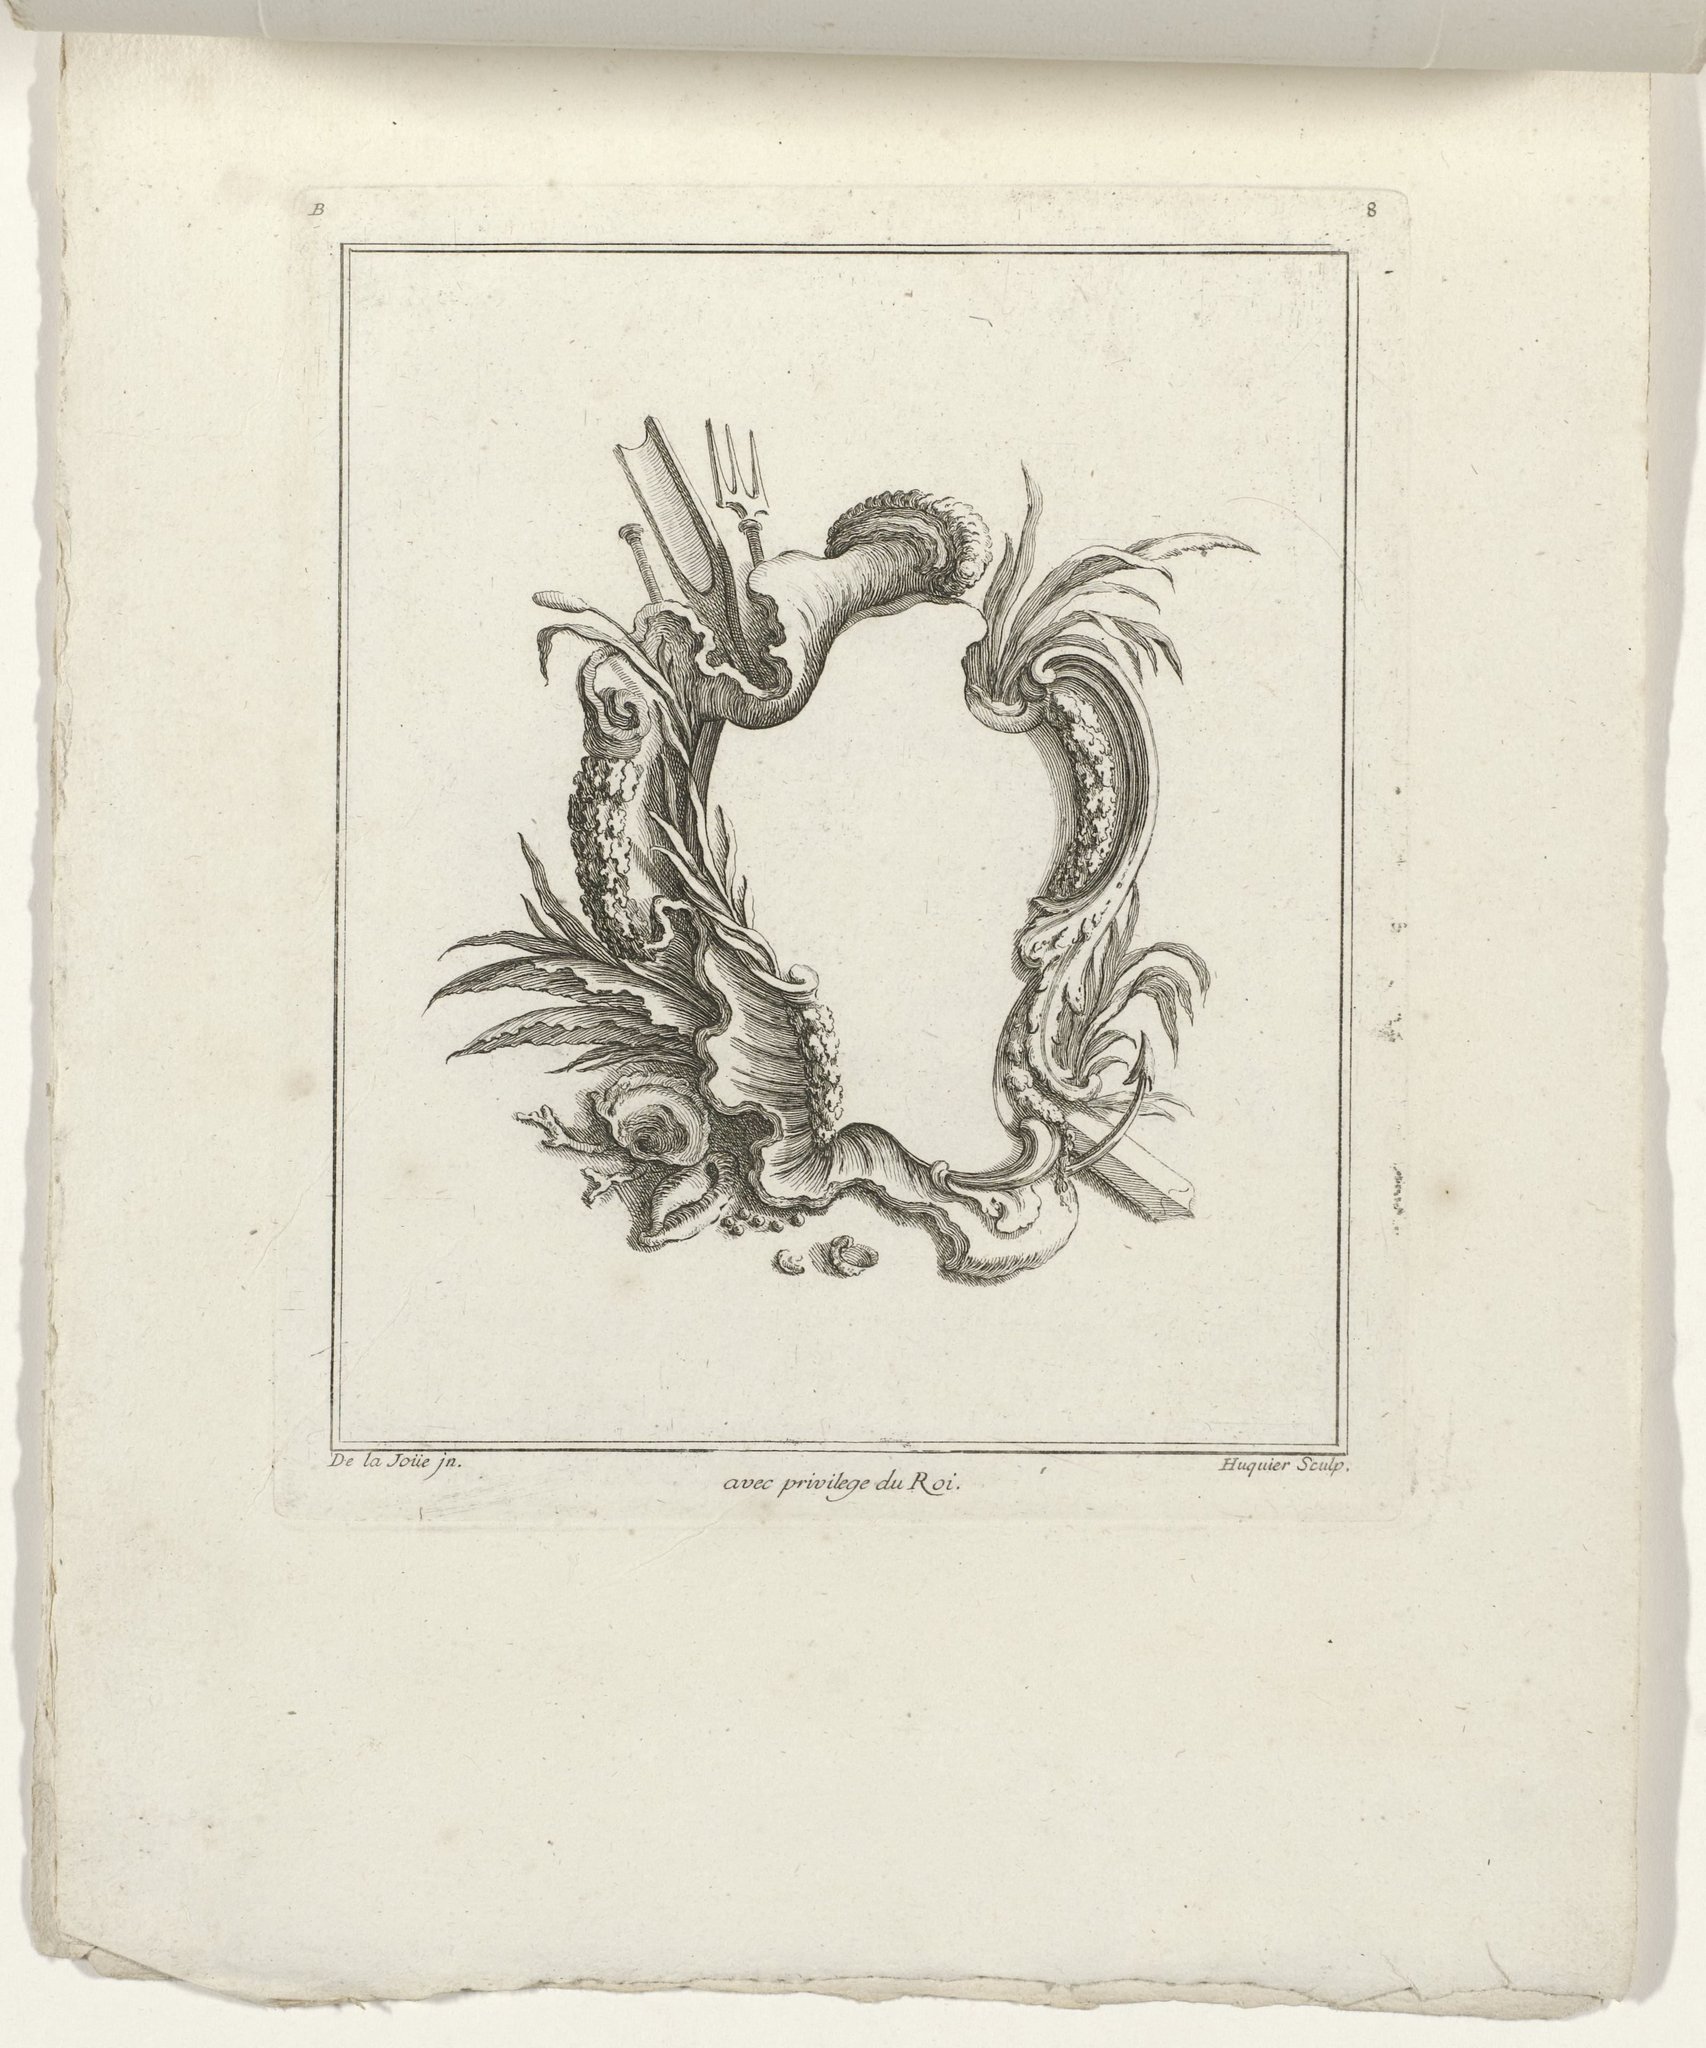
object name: ornament print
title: Cartouche bekroond met drietand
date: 1710-1772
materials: paper, fiber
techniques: engraving, etching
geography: paris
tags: ornament derived from plant forms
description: Cartouche bekroond met drietand omgeven door bladeren en linksonder enkele schelpen. Onderdeel van een reeks van twaalf genummerde ornamentprenten.